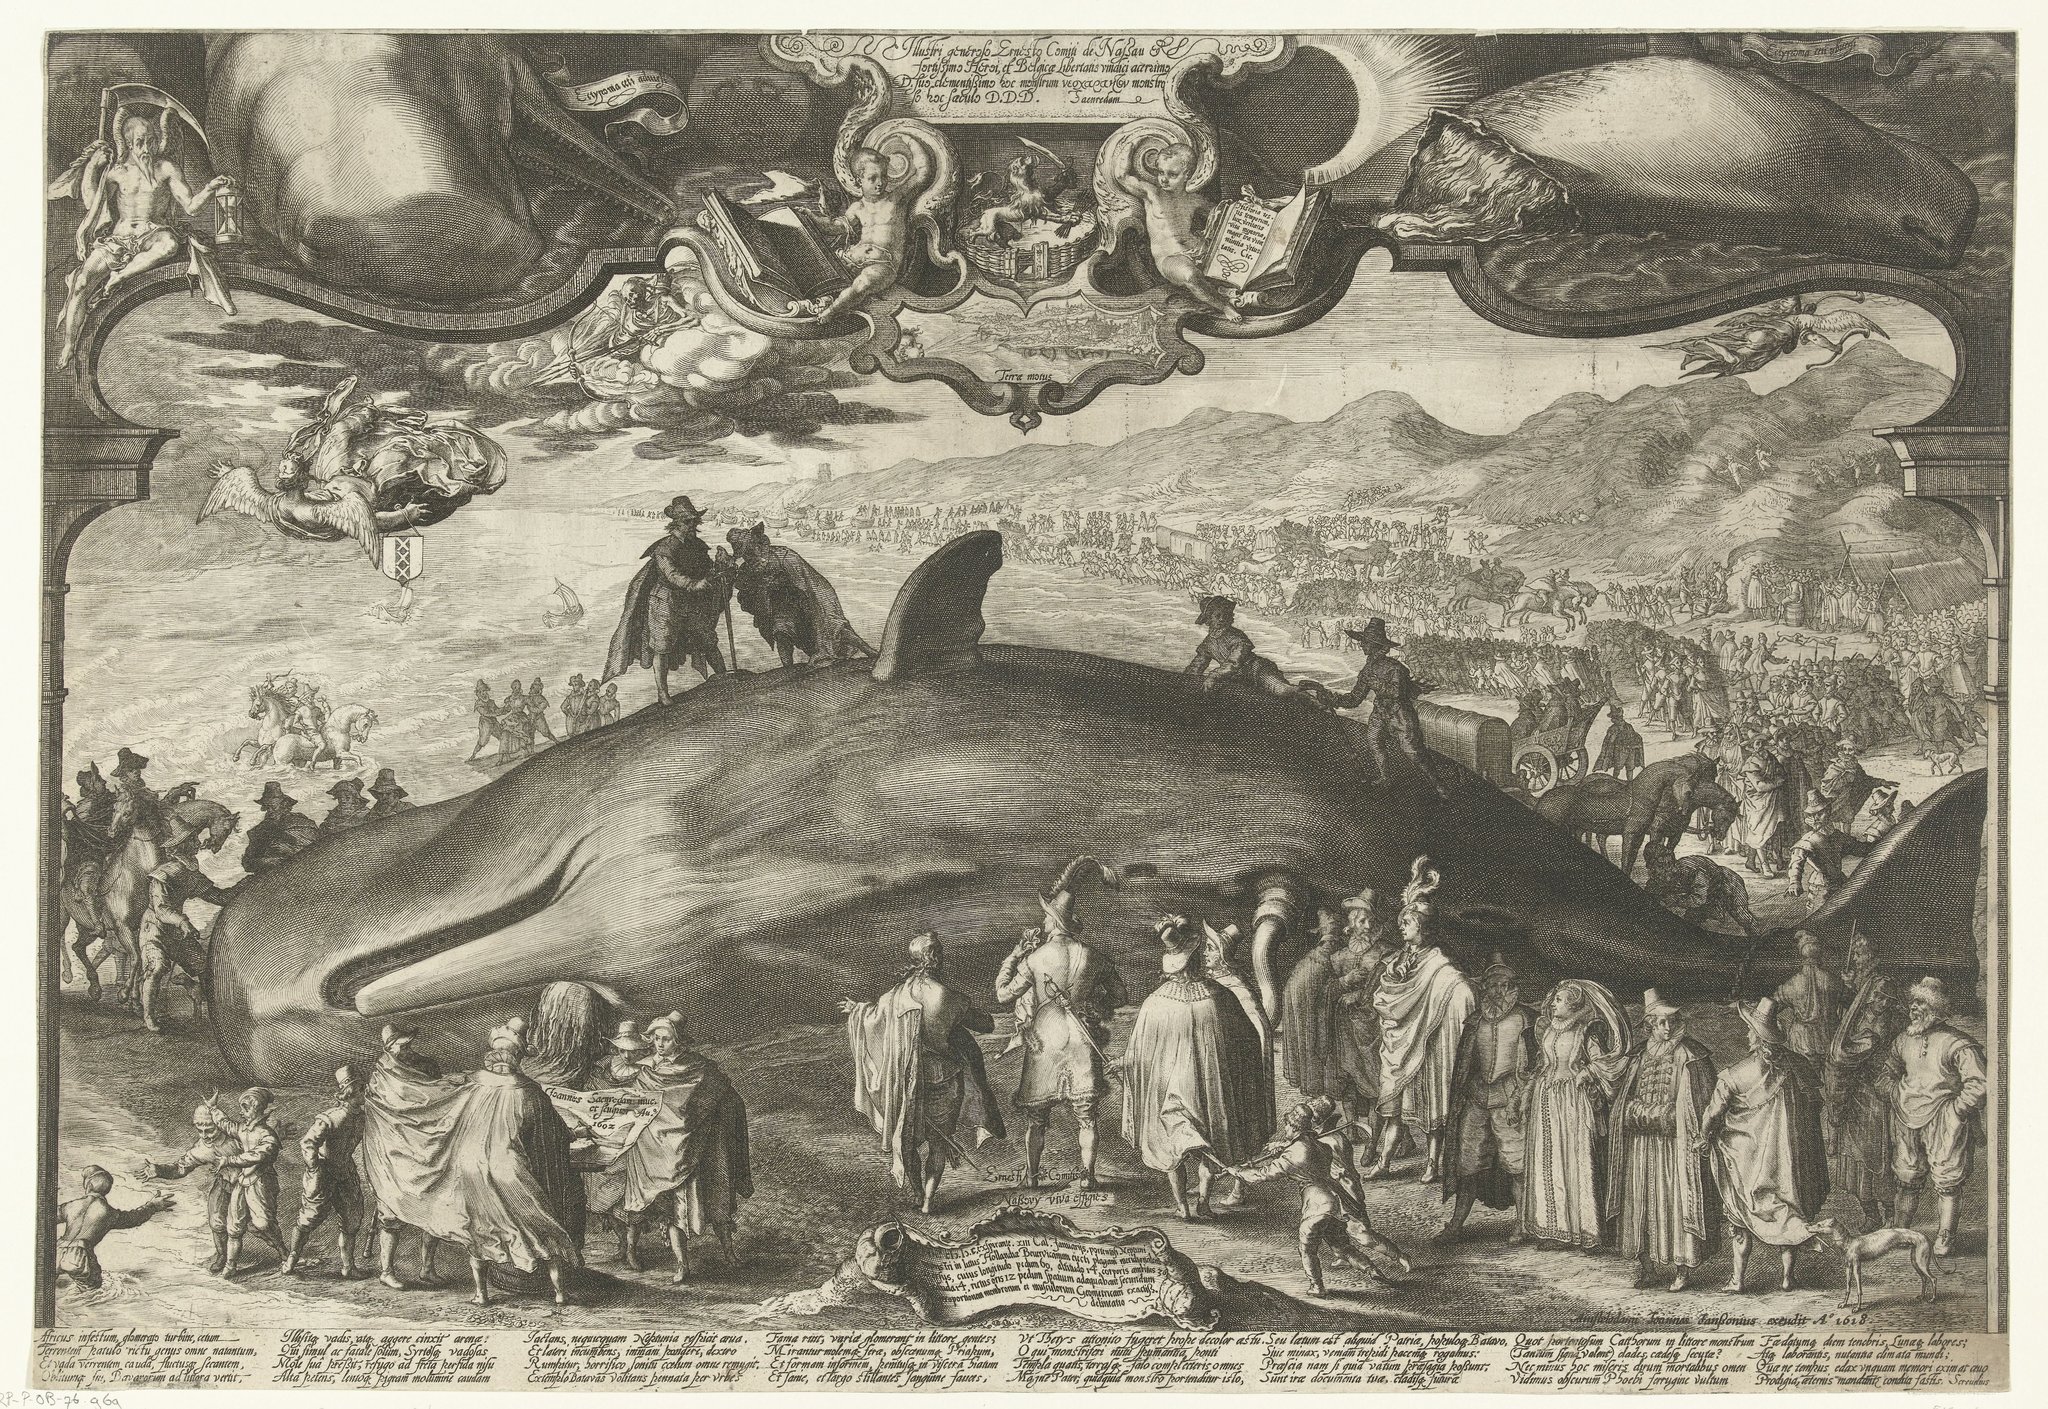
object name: print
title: Walvis, op 13 januari 1601 aangespoeld bij Beverwijk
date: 1602-1608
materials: paper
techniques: engraving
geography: amsterdam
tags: ernst casimir graaf van nassau-dietz, clothes, costume (+ men's clothes), swimming mammals: whale (+ dying animal; death of animal; dead animal), draughtsman at work - cc - out of doors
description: Walvis (potvis), op 13 januari 1601 aangespoeld bij Beverwijk. Op de voorgrond graaf Ernst Casimir van Nassau, de schilder met een papier in de hand met zijn tekening, een menigte toeschouwers en op de achtergrond links de zee; rechts het strand met wagens en mensen. Bovenaan de kop van de walvis van twee kanten te zien. Daartussen een opdracht in het Latijn aan graaf Ernst Casimir door Saenredam, en de verduisterde zon en maan. Daaronder een aardbeving en de dood die een pijl op de Amsterdamse Maagd afschiet als zinspeling op de verschrikkingen die men door de komst van de walvis verwachtte. In het onderschrift een 32-regelig vers in het Latijn.